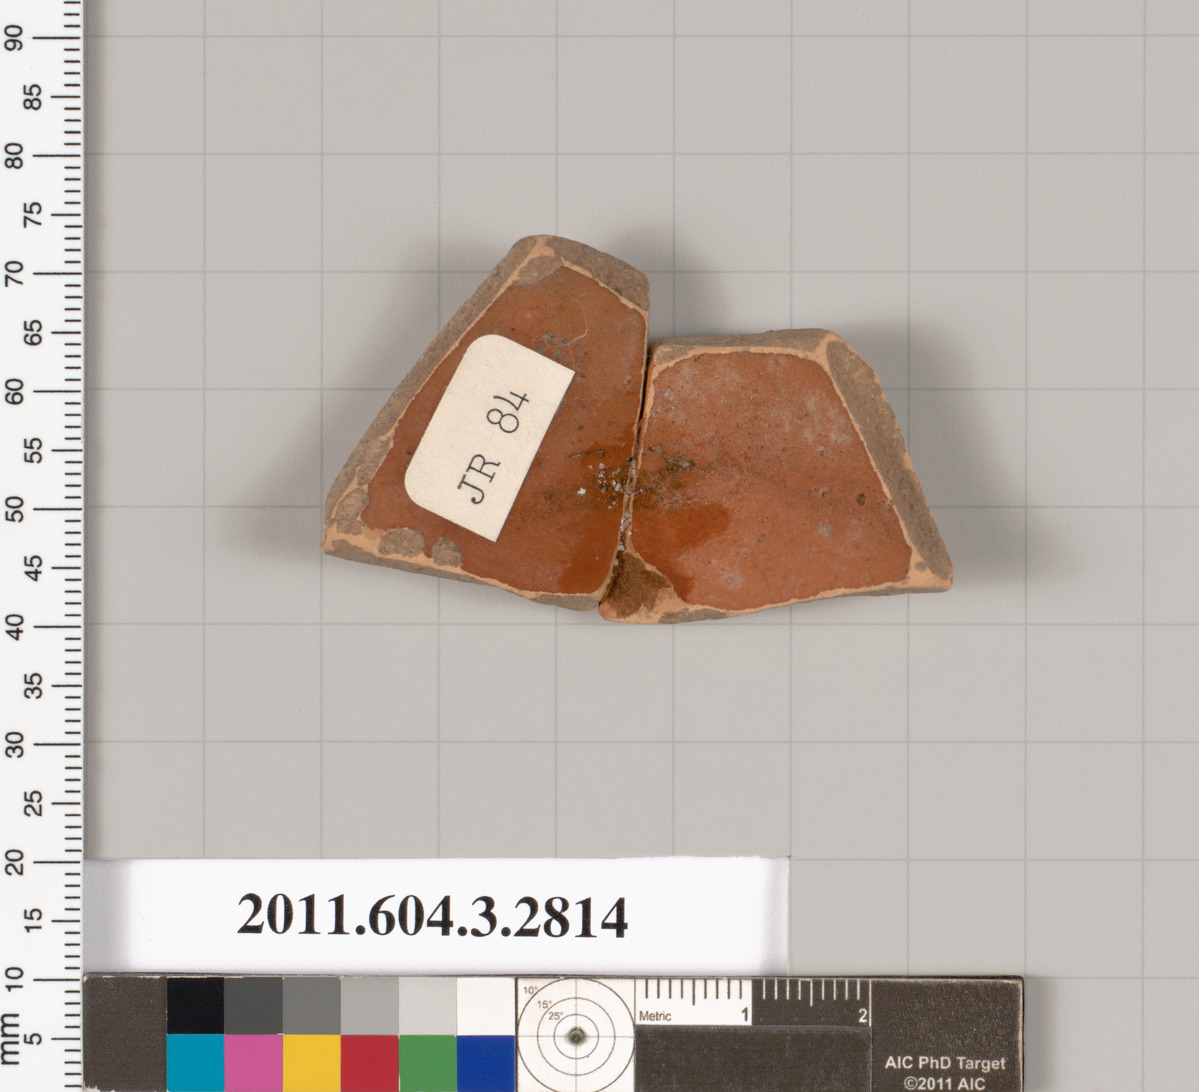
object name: kylix fragment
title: Terracotta fragment of a kylix (cup)?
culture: greek, attic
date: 600-401 BCE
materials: terracotta